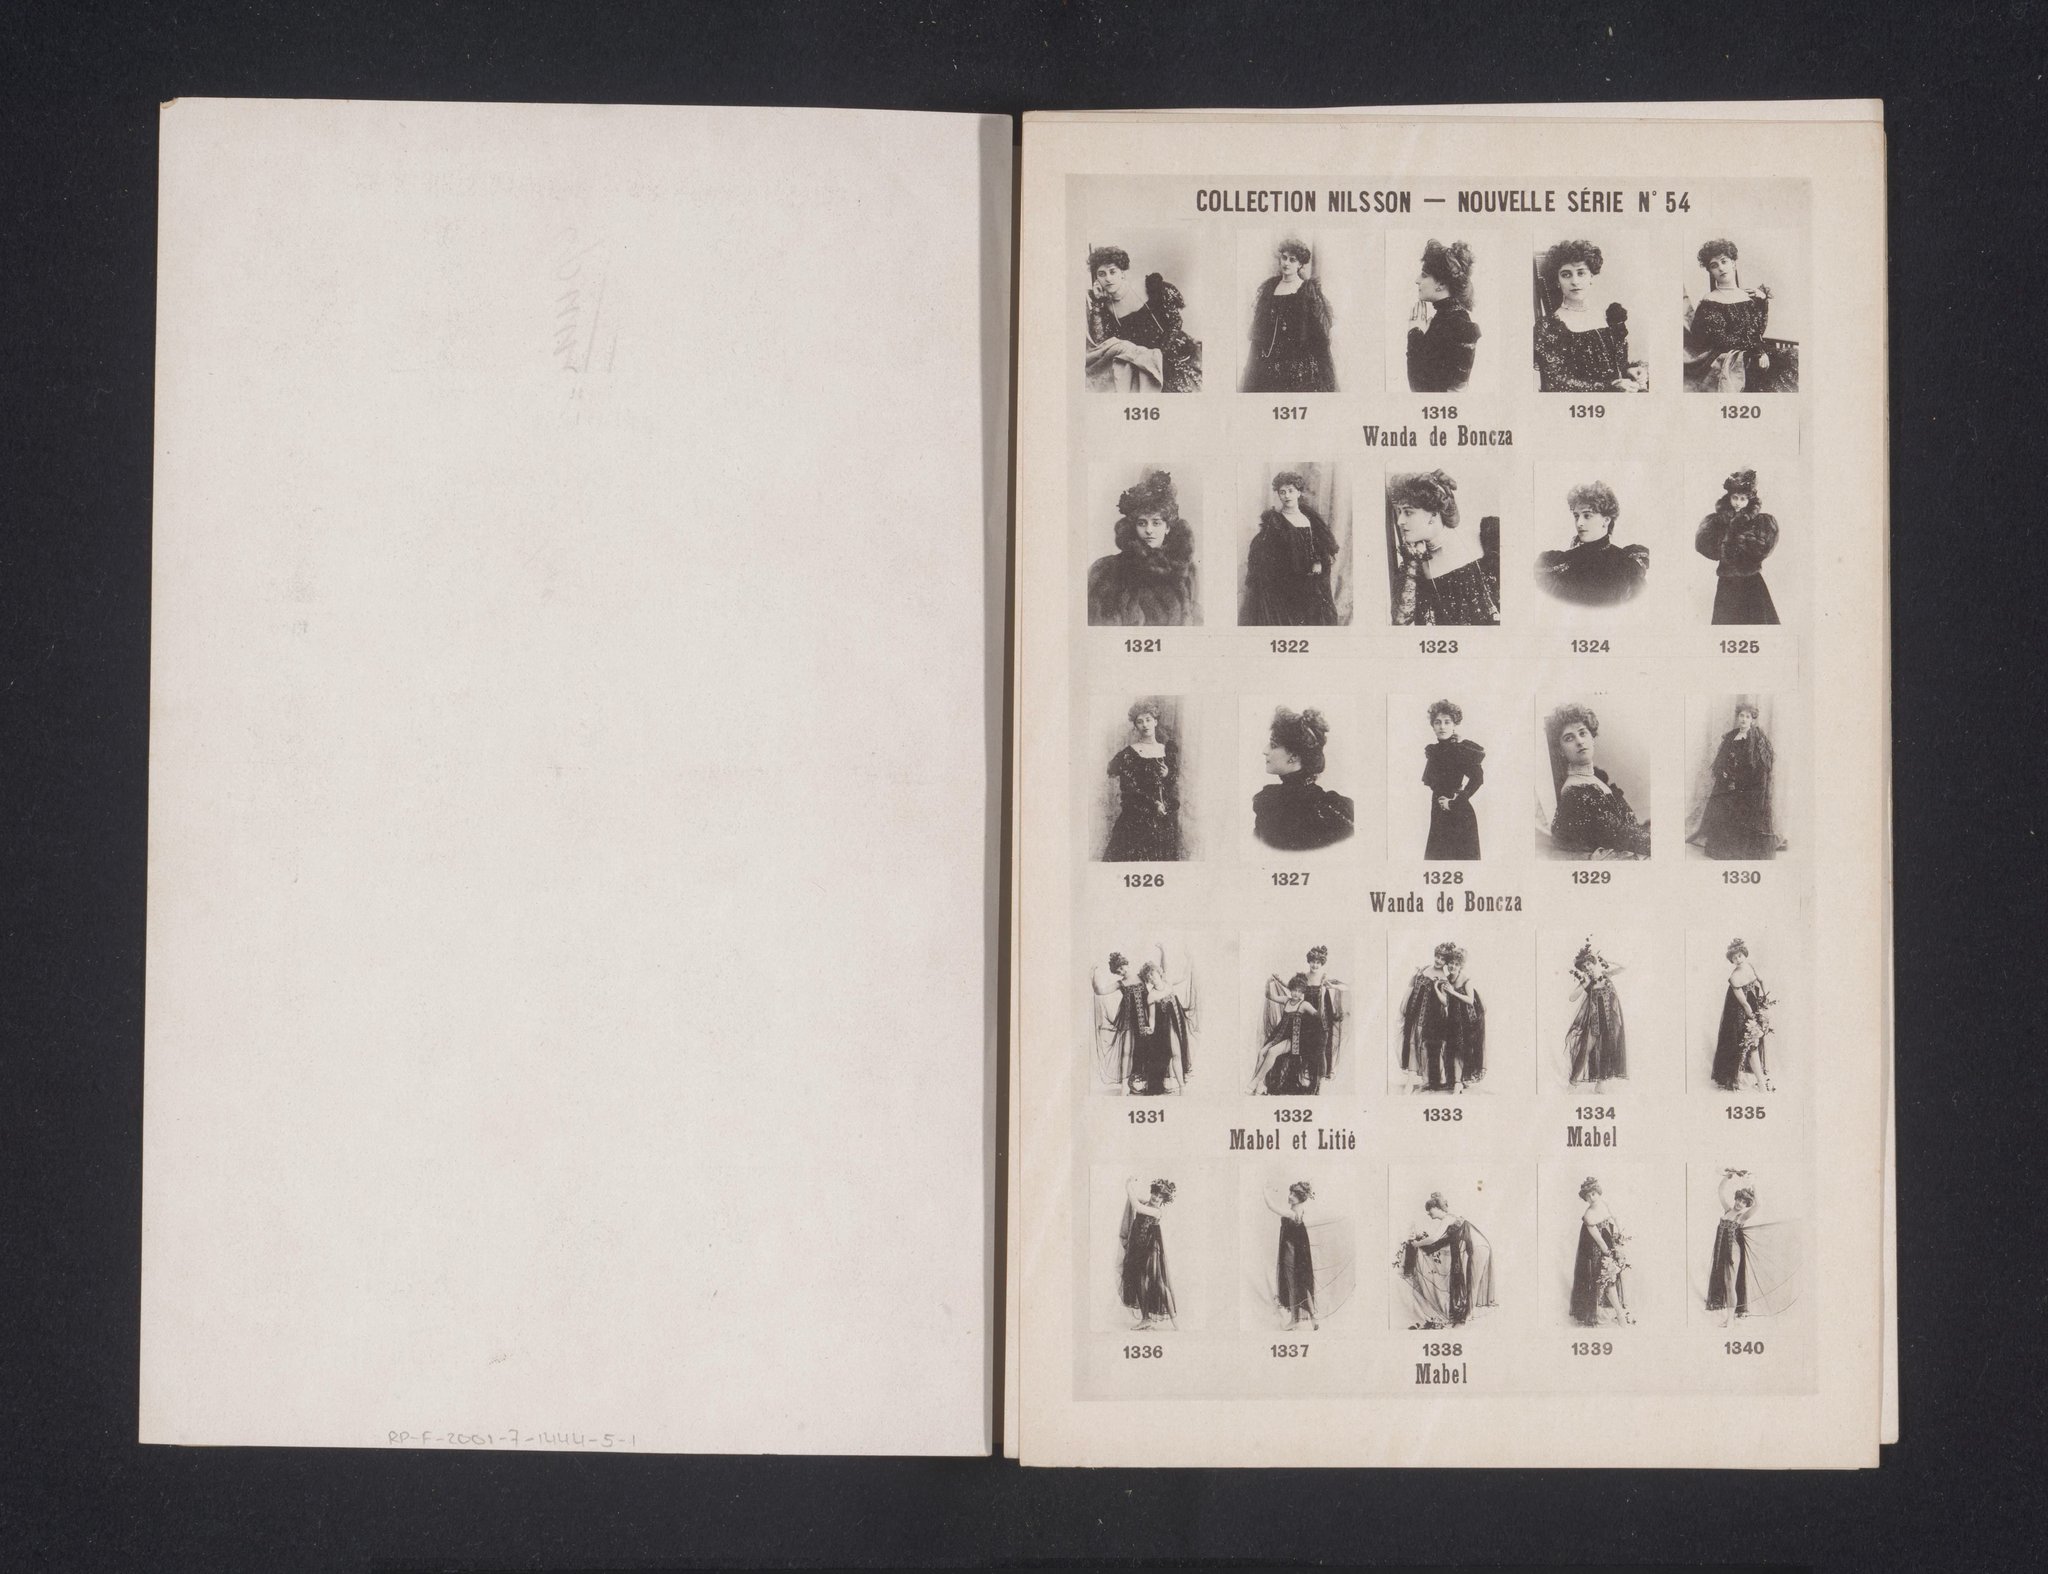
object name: page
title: 25 portretten van Wanda de Boncza en Mabel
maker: Anonymous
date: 1892-1897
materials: paper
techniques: photograph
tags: historical persons - bb - woman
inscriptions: number: ‘No 54’